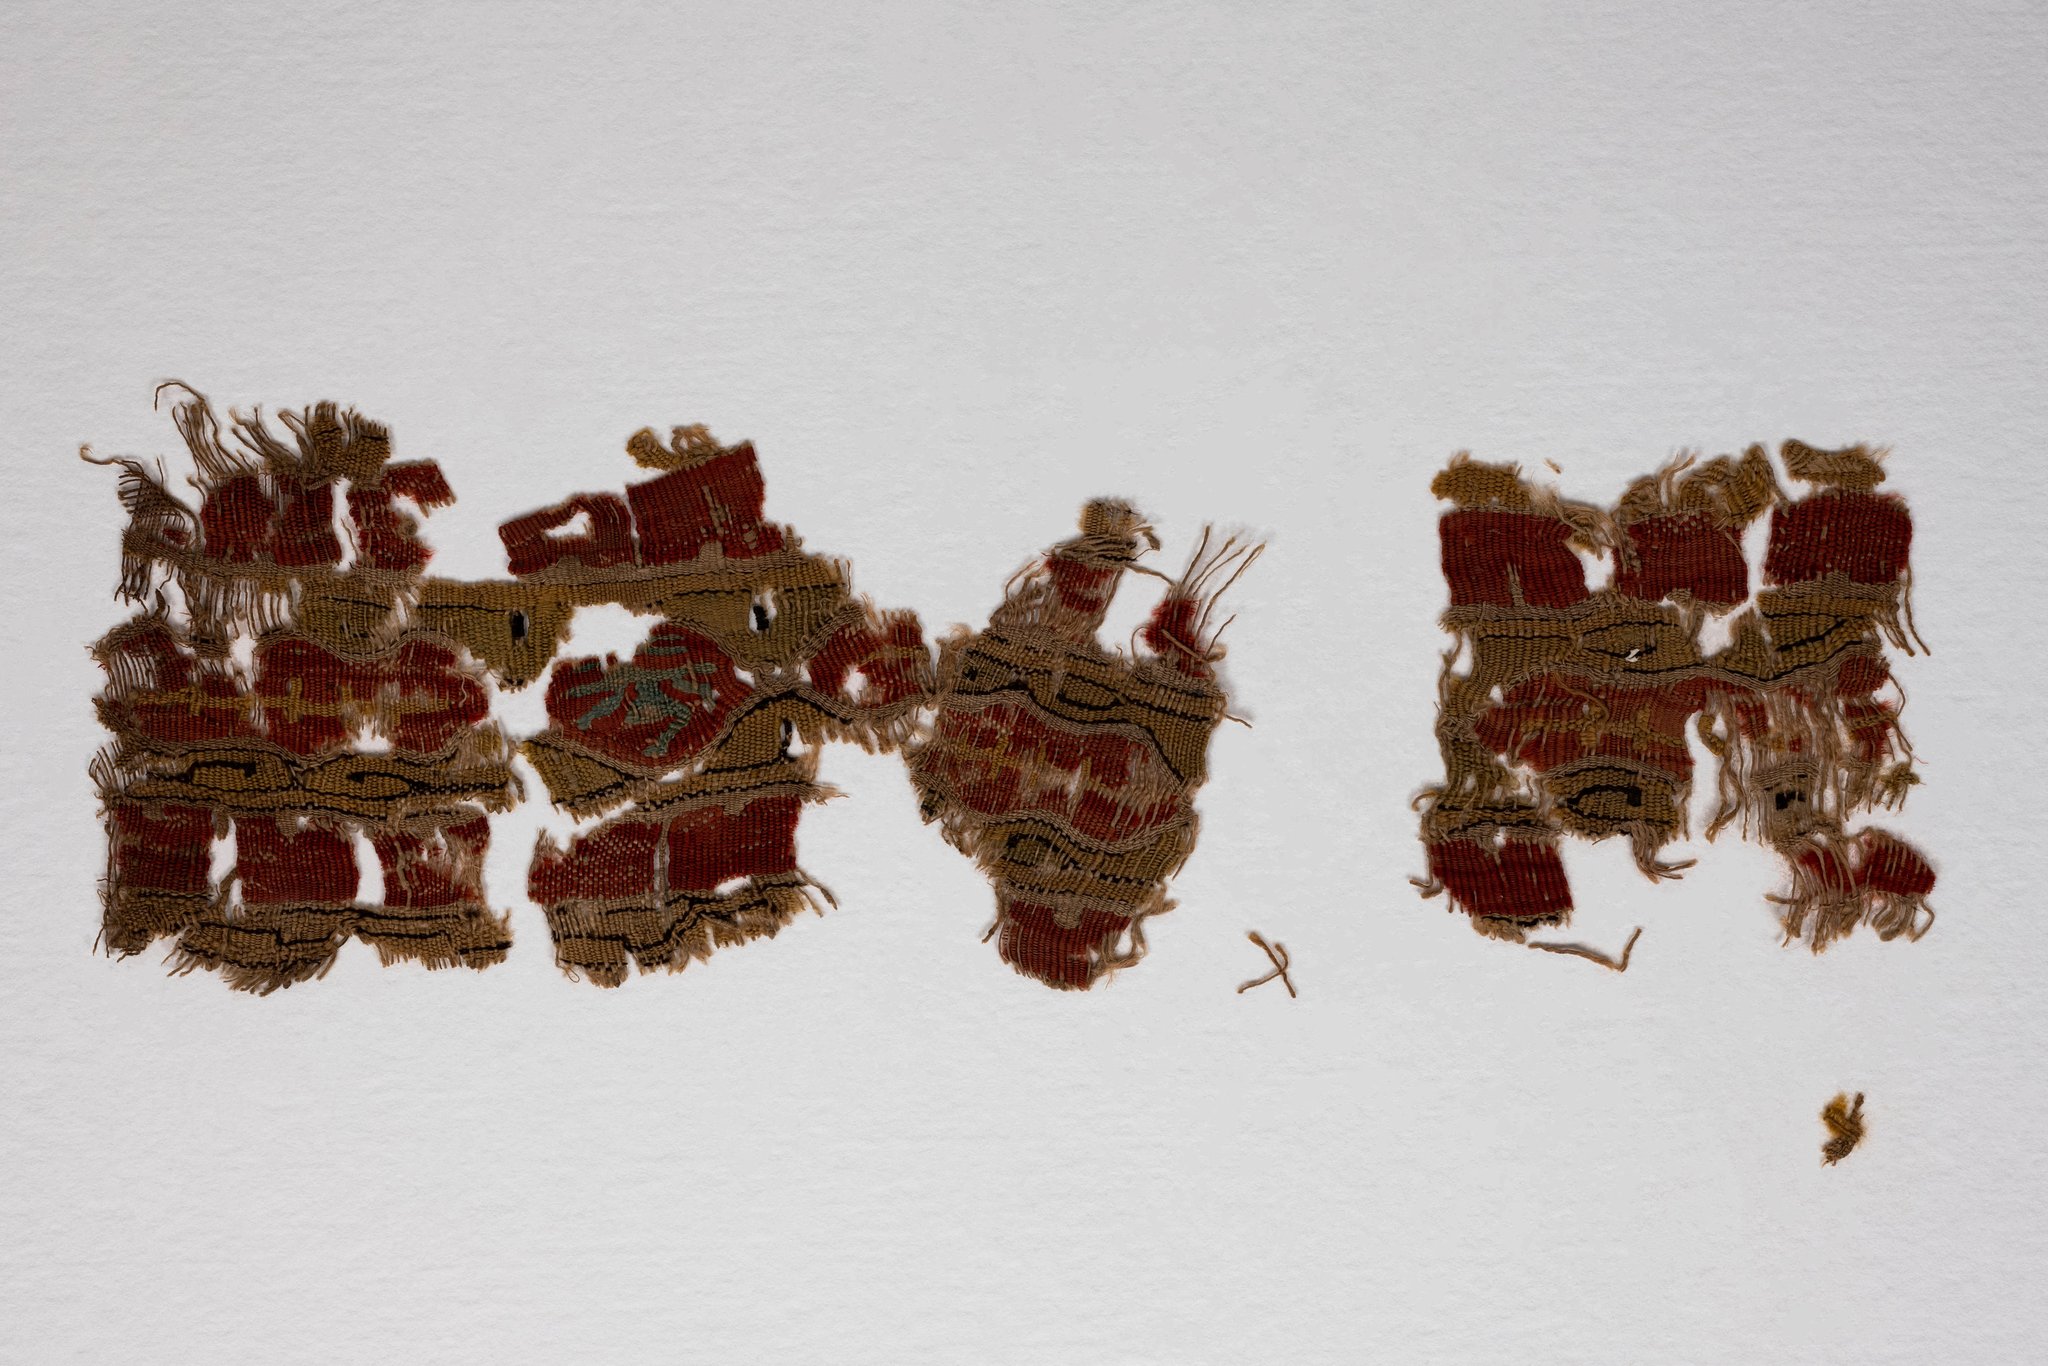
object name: band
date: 1001-1200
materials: linen, silk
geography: egypt